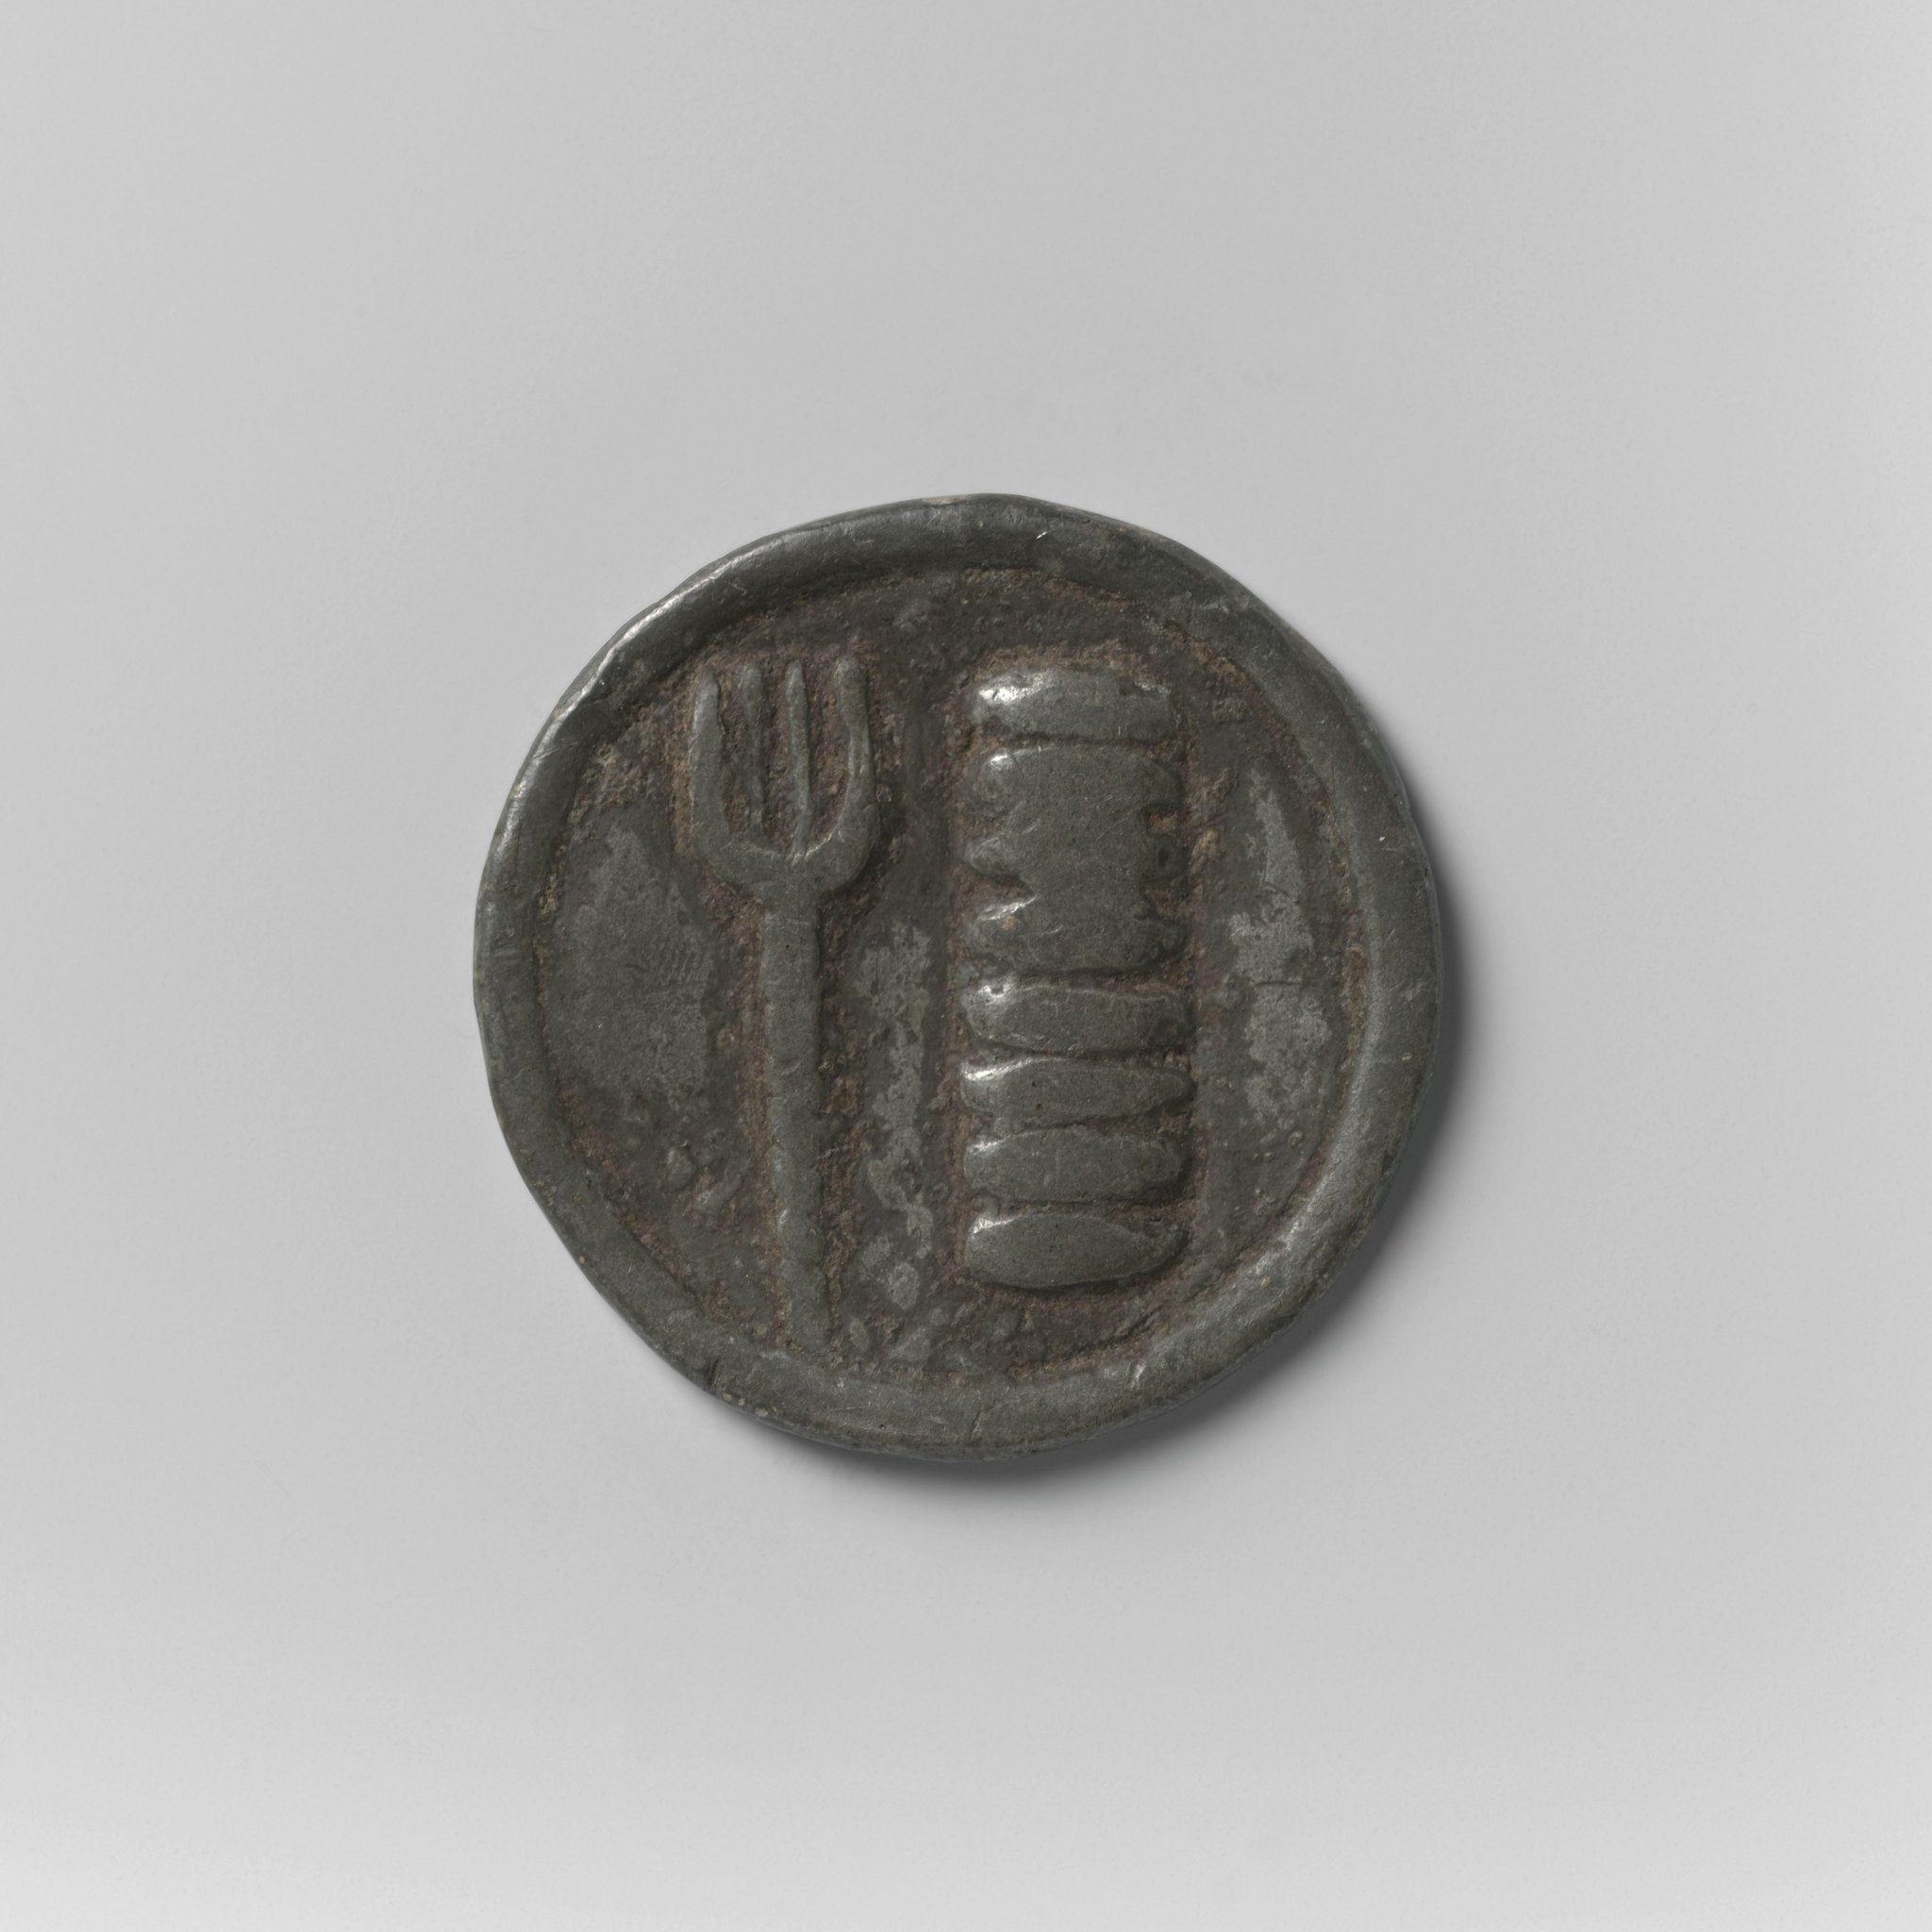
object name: history medal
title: Broodloodje van het Bakkers- en Brouwersgilde te Arnhem, 19e eeuw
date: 1800-1900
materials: lead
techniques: casting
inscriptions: inscription: ‘B B / G’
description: Gegoten loden penning, op de voorzijde een broodschoof en een stapel broden, op de keerzijde de letters BBG